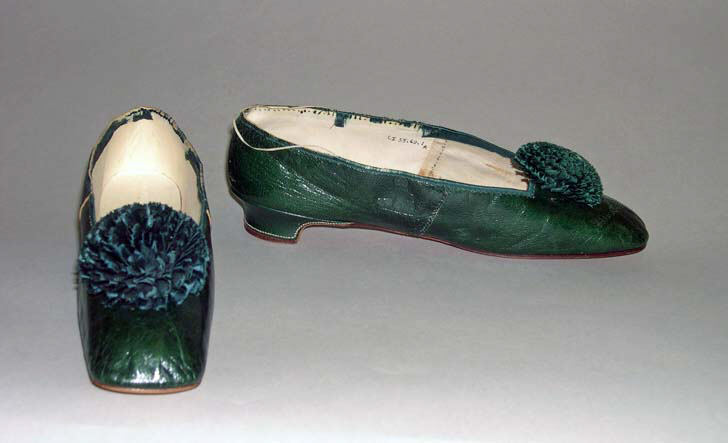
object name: slipper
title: Slippers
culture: french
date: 1850-1859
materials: leather, linen, wood